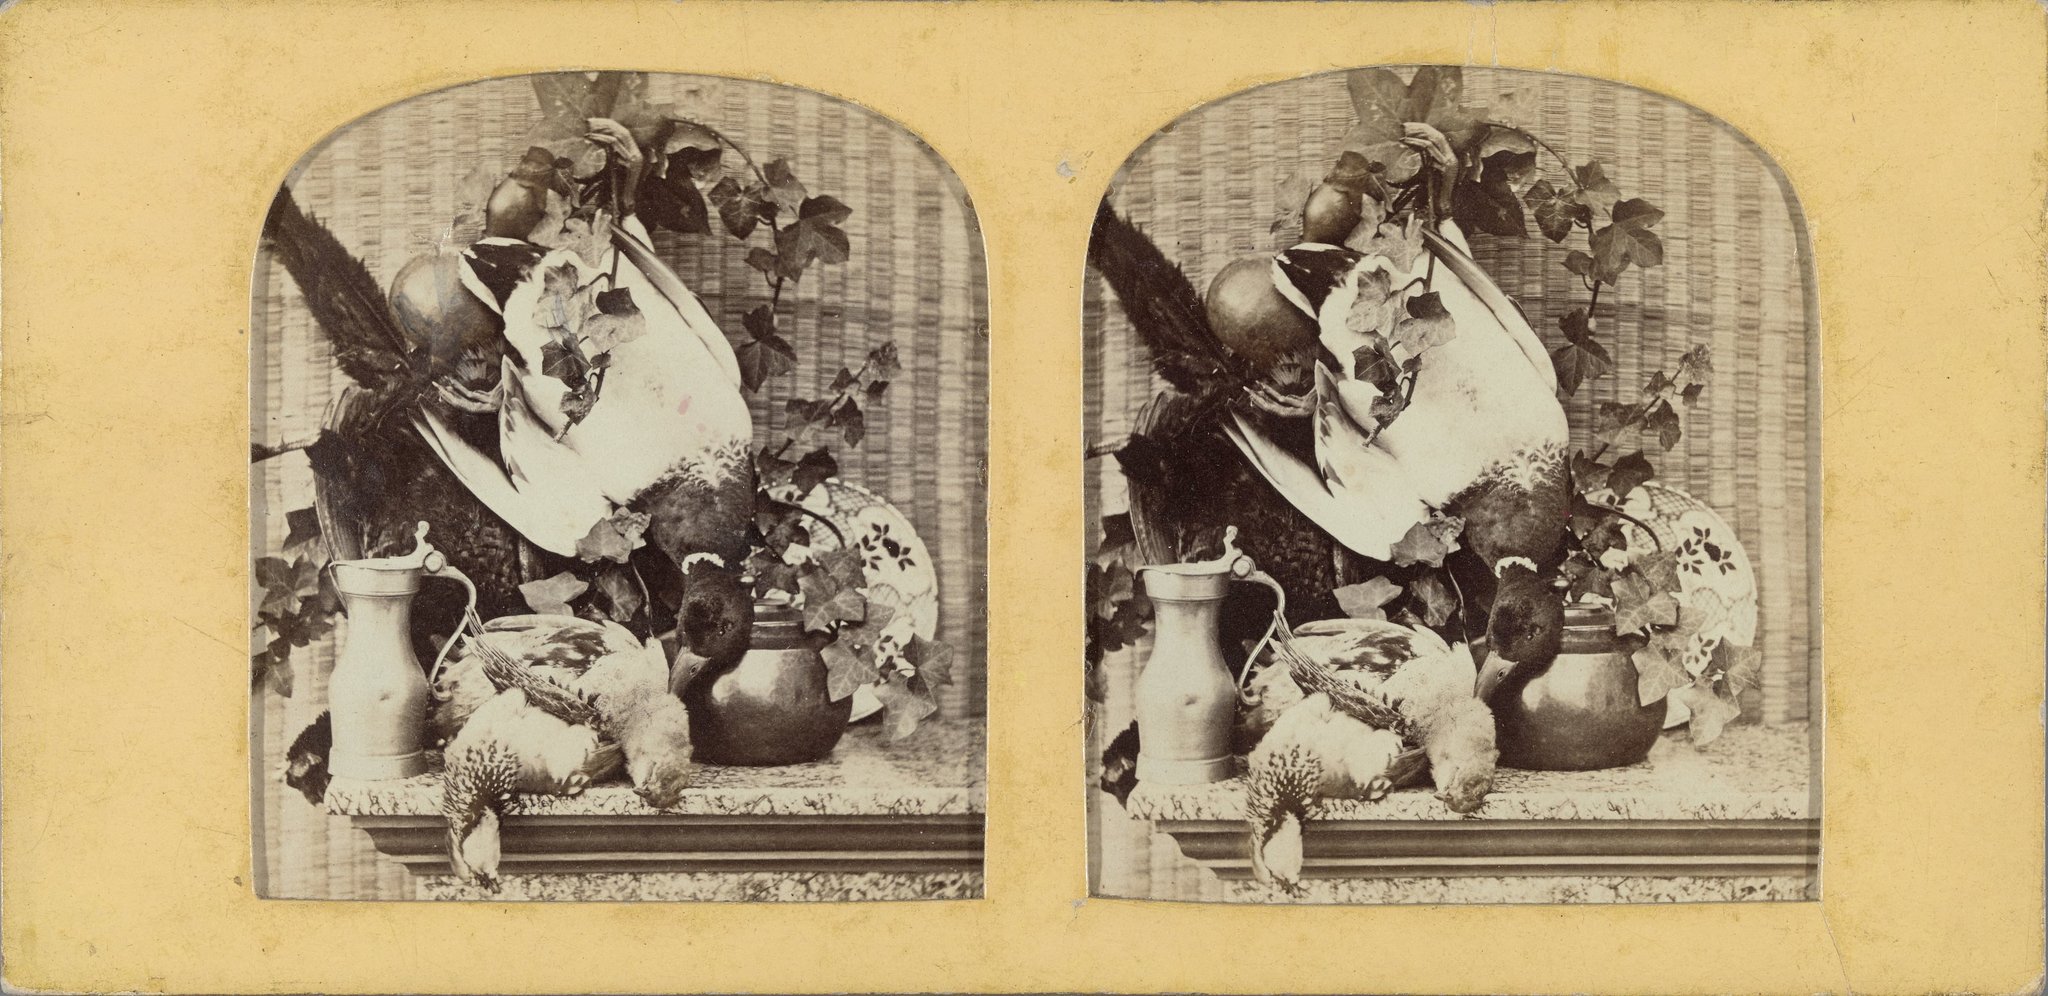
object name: tissue stereograph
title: Stilleven met gevogelte, kruiken en planten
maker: Anonymous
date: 1860-1890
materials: cardboard, paper, photographic support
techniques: albumen print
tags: bird hunting, still life of miscellaneous objects